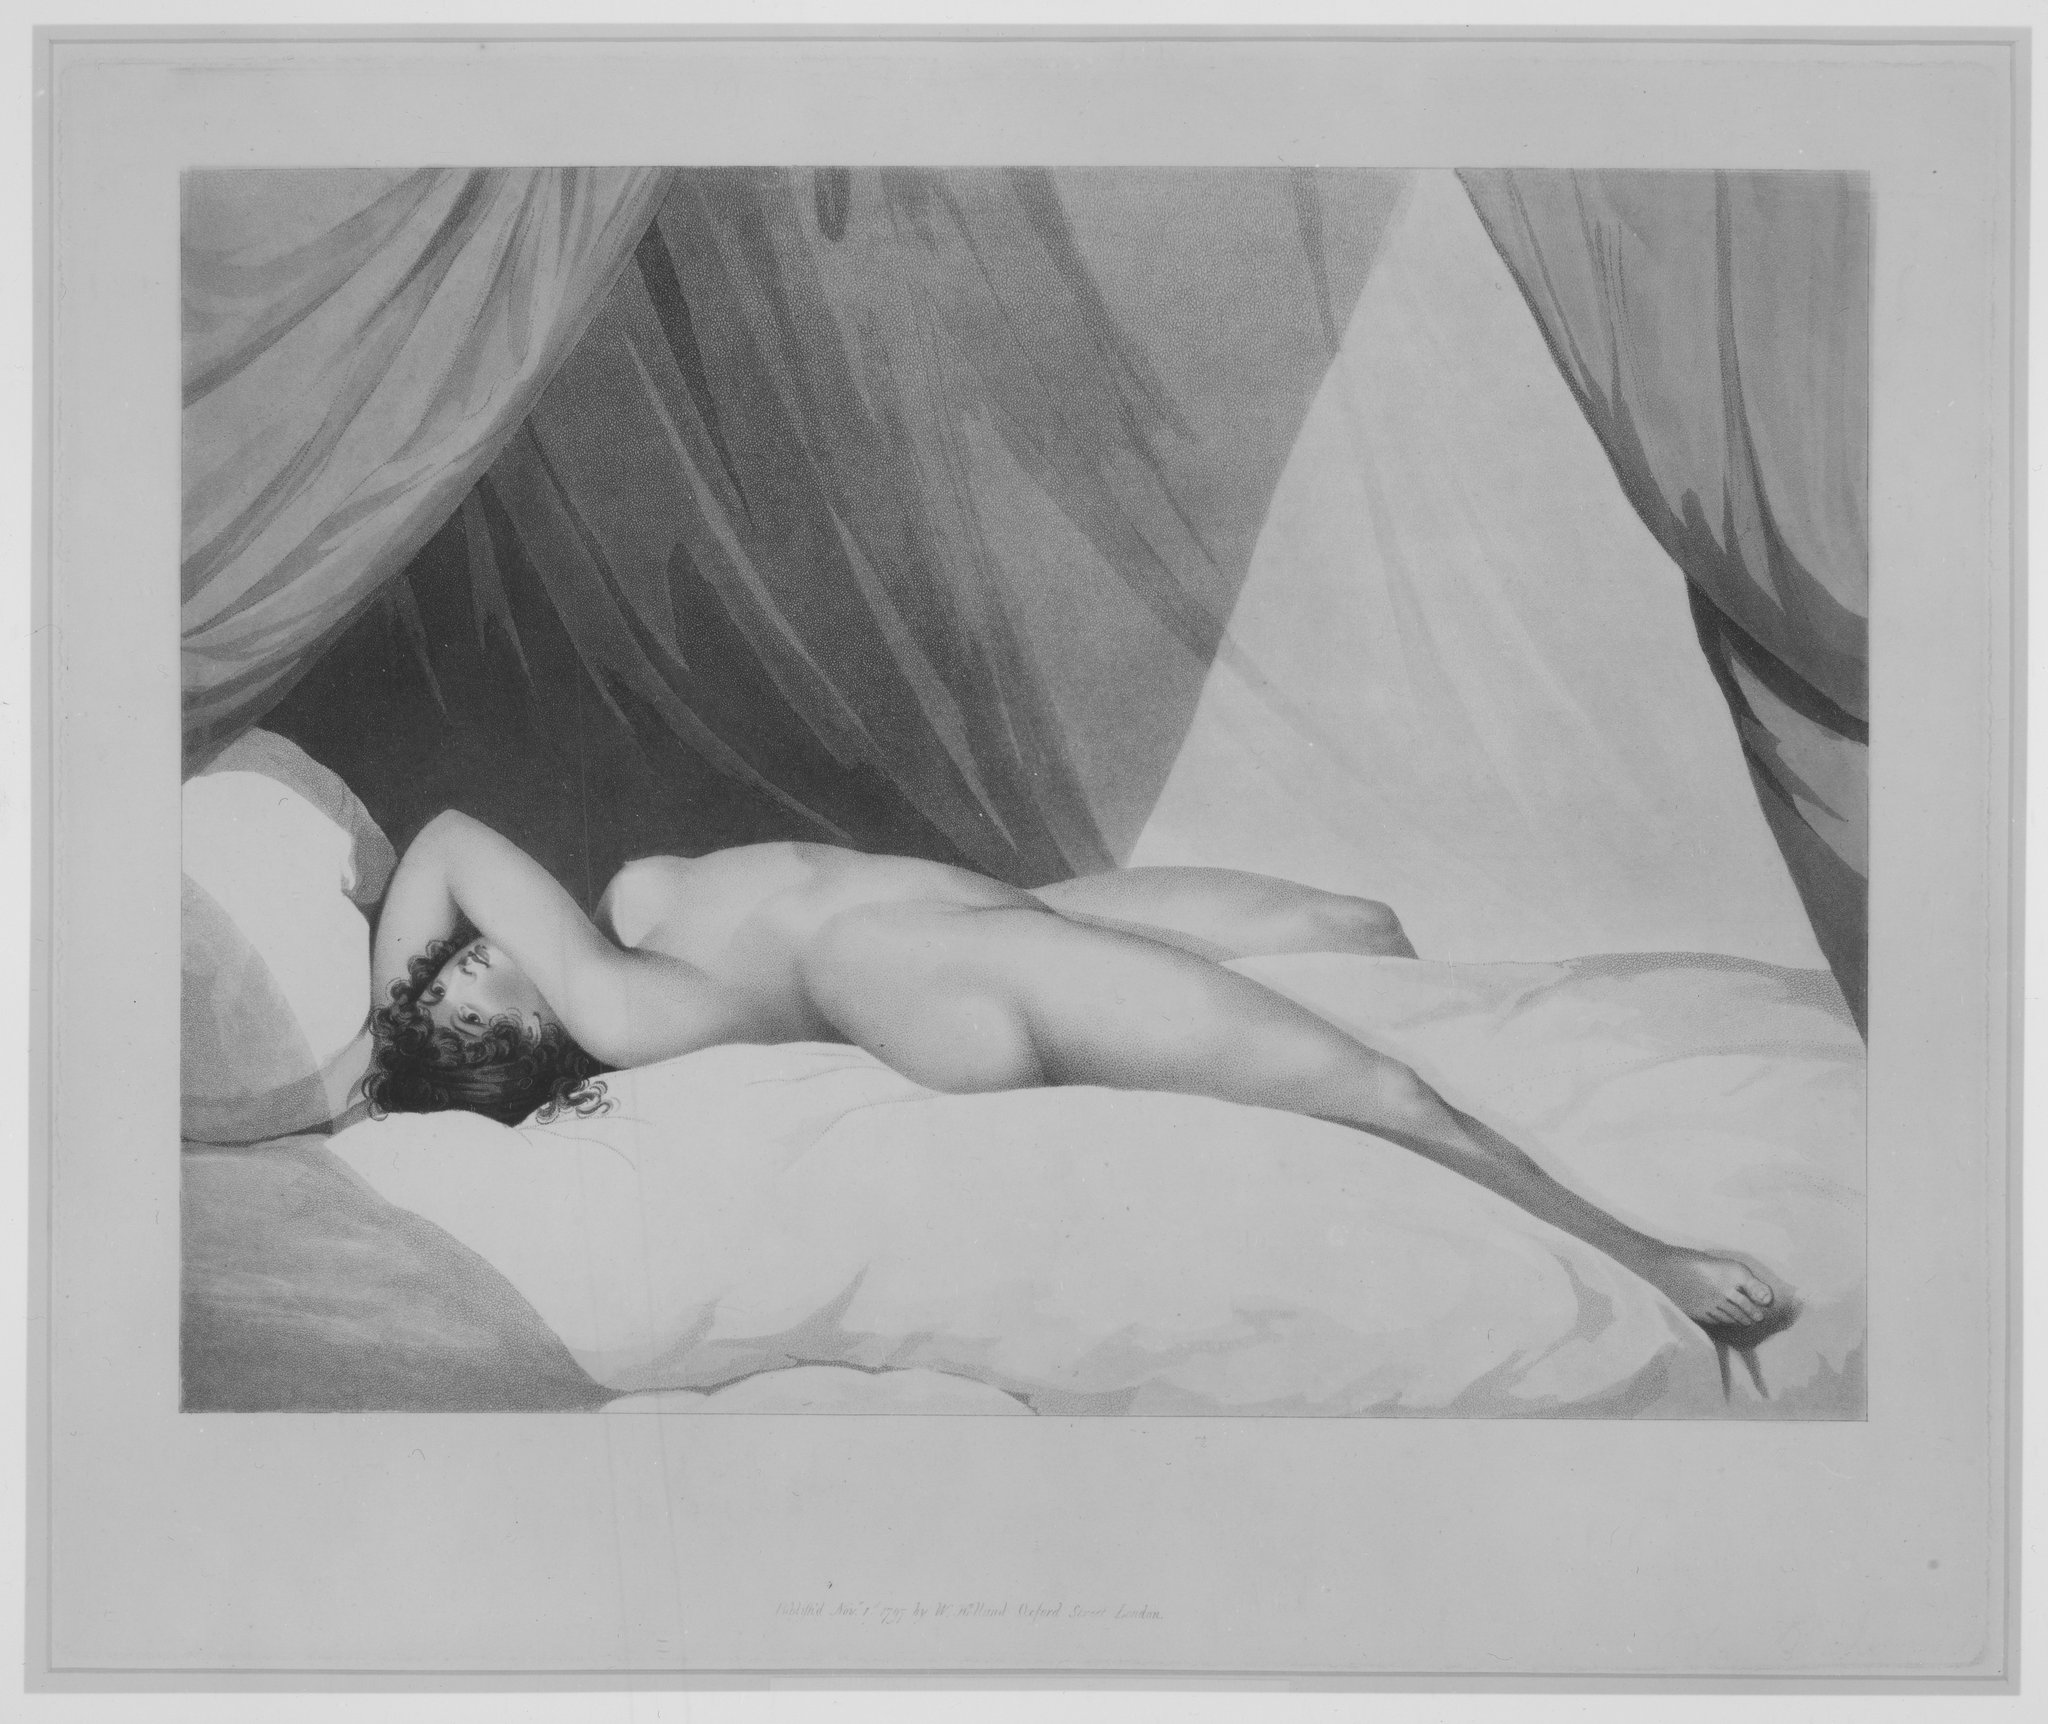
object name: print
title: Nude Reclining on Curtained Bed [Emma Hamilton (?)]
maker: adam buck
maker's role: artist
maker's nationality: irish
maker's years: 1759-1833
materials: watercolor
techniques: aquatint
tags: female nudes,beds